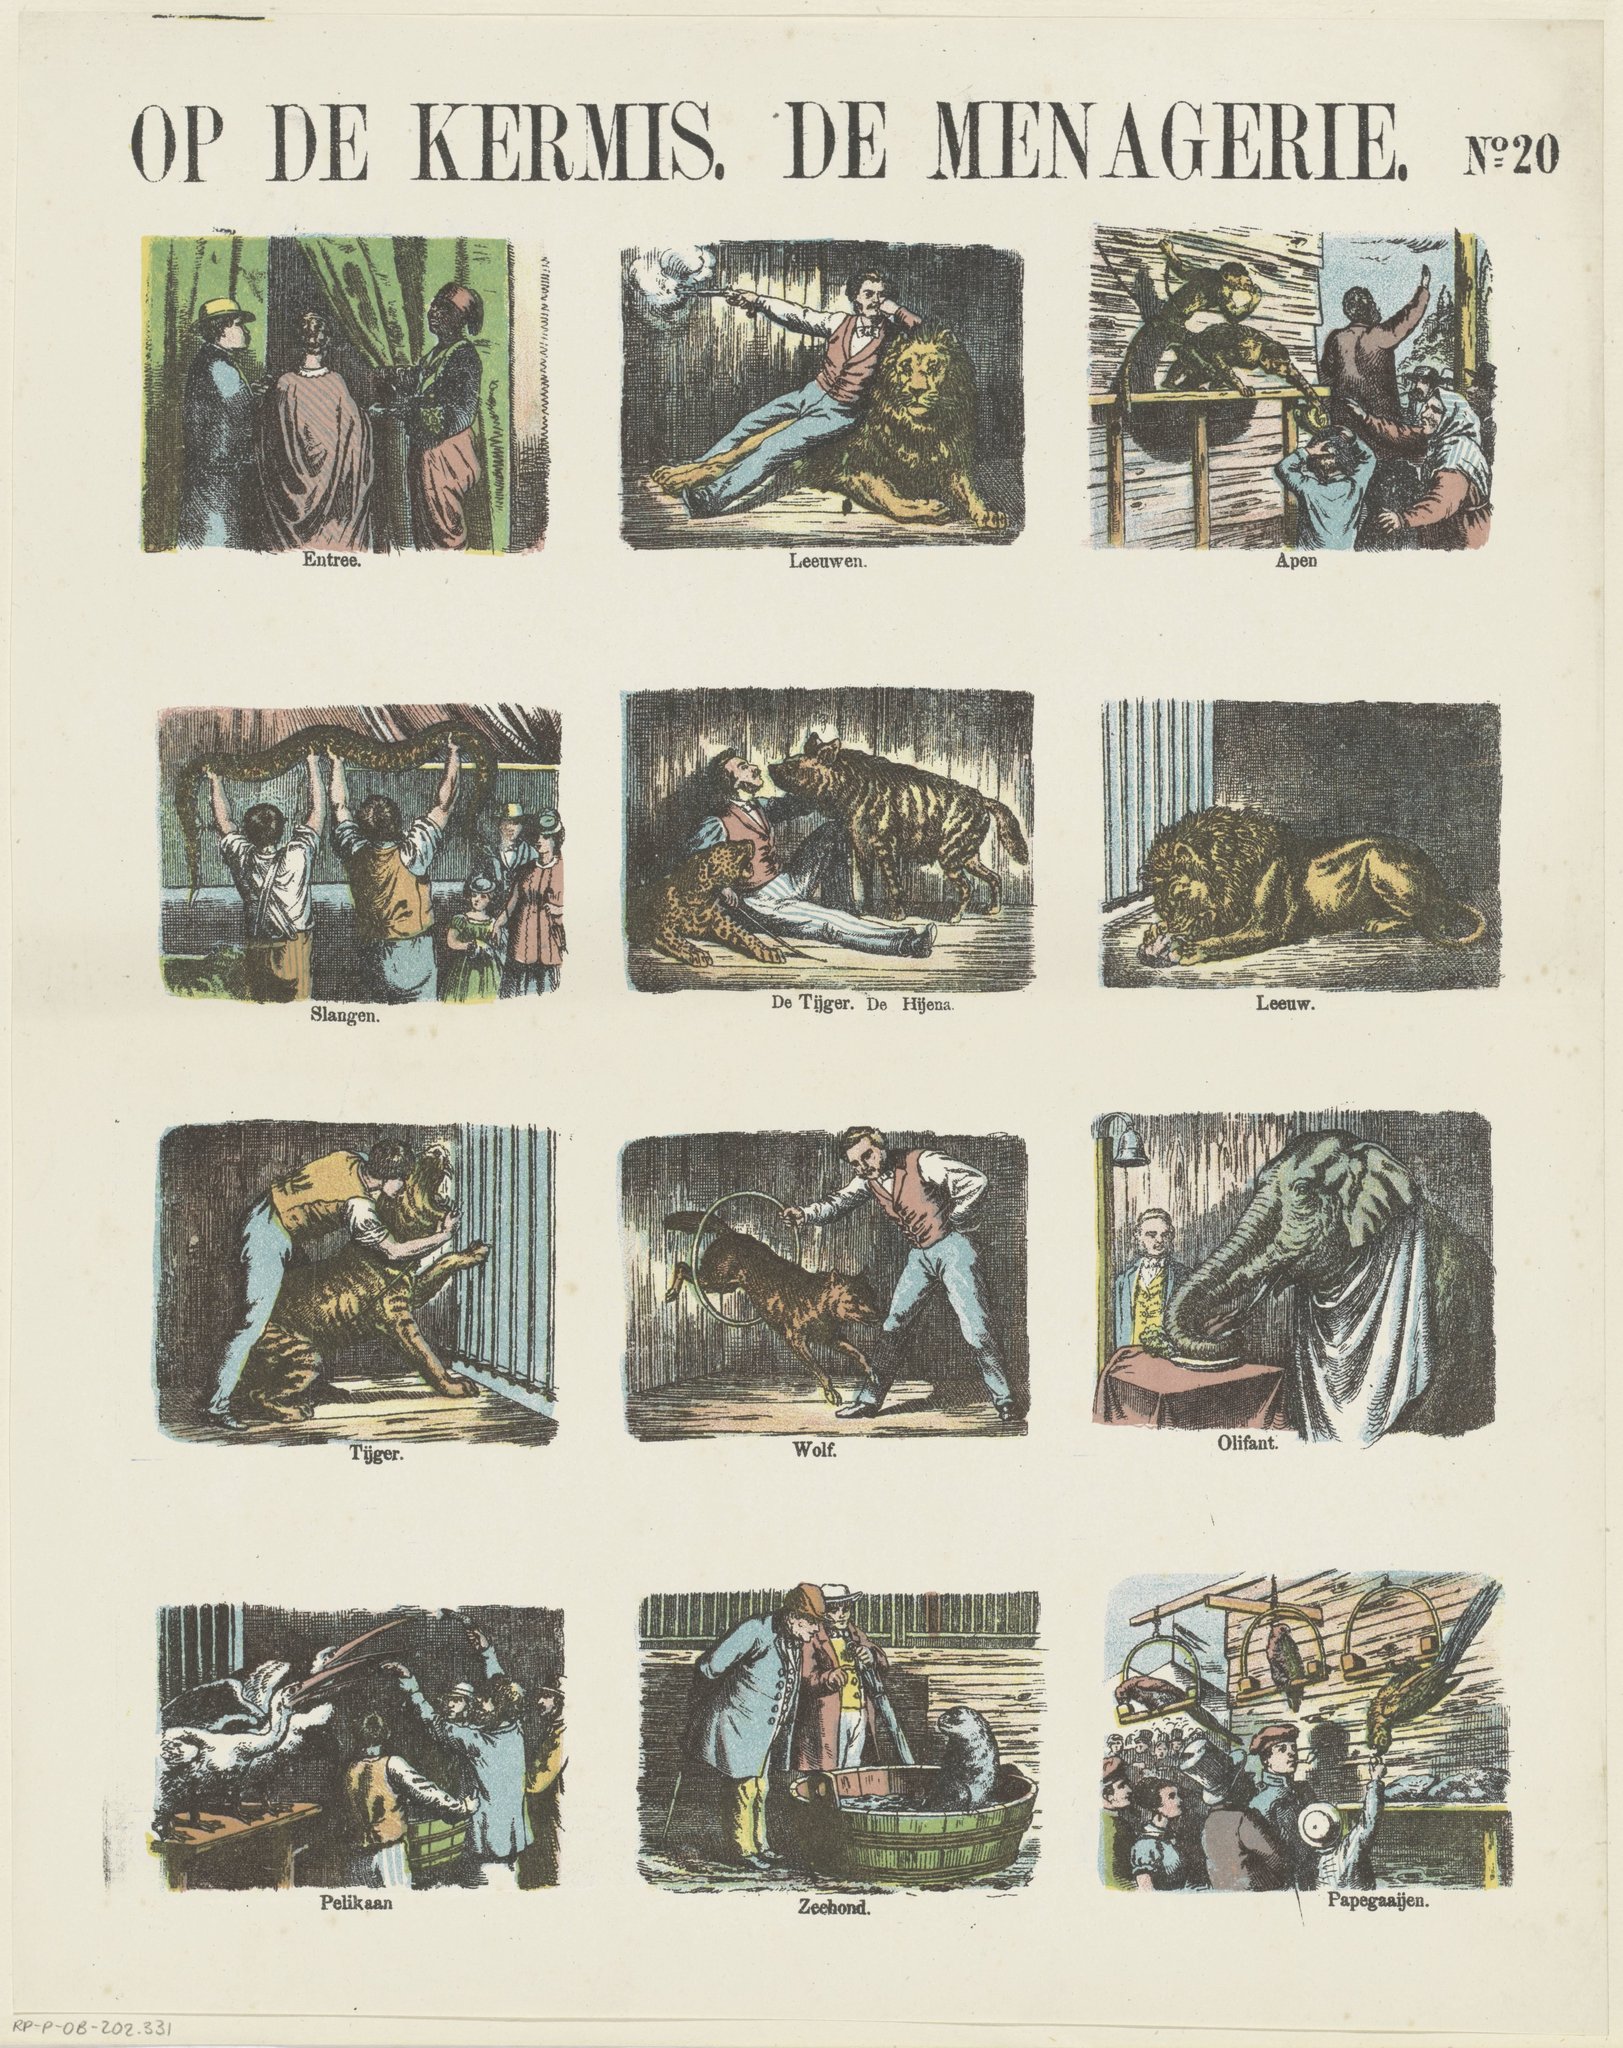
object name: popular print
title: Meijer's prenten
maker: Anonymous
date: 1873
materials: paper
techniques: lithograph, letterpress printing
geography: amsterdam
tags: taming and training of animals, circus animals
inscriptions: collector's mark: Lugt 2760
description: Blad met 12 voorstellingen van circusdieren en hun trainers, waaronder een leeuw, apen, een olifant en een zeehond. Onder elke afbeelding een onderschrift. Genummerd rechtsboven: No. 20.